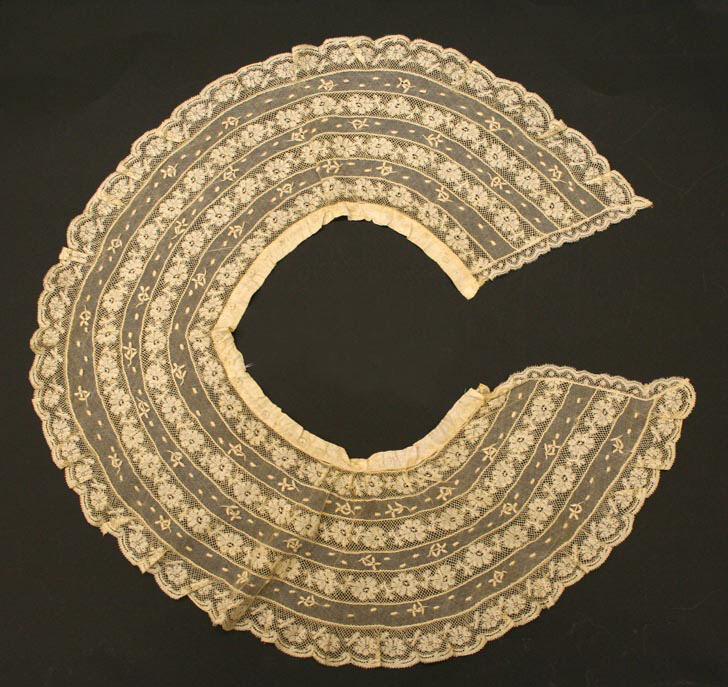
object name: collar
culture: american or european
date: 1700-1945